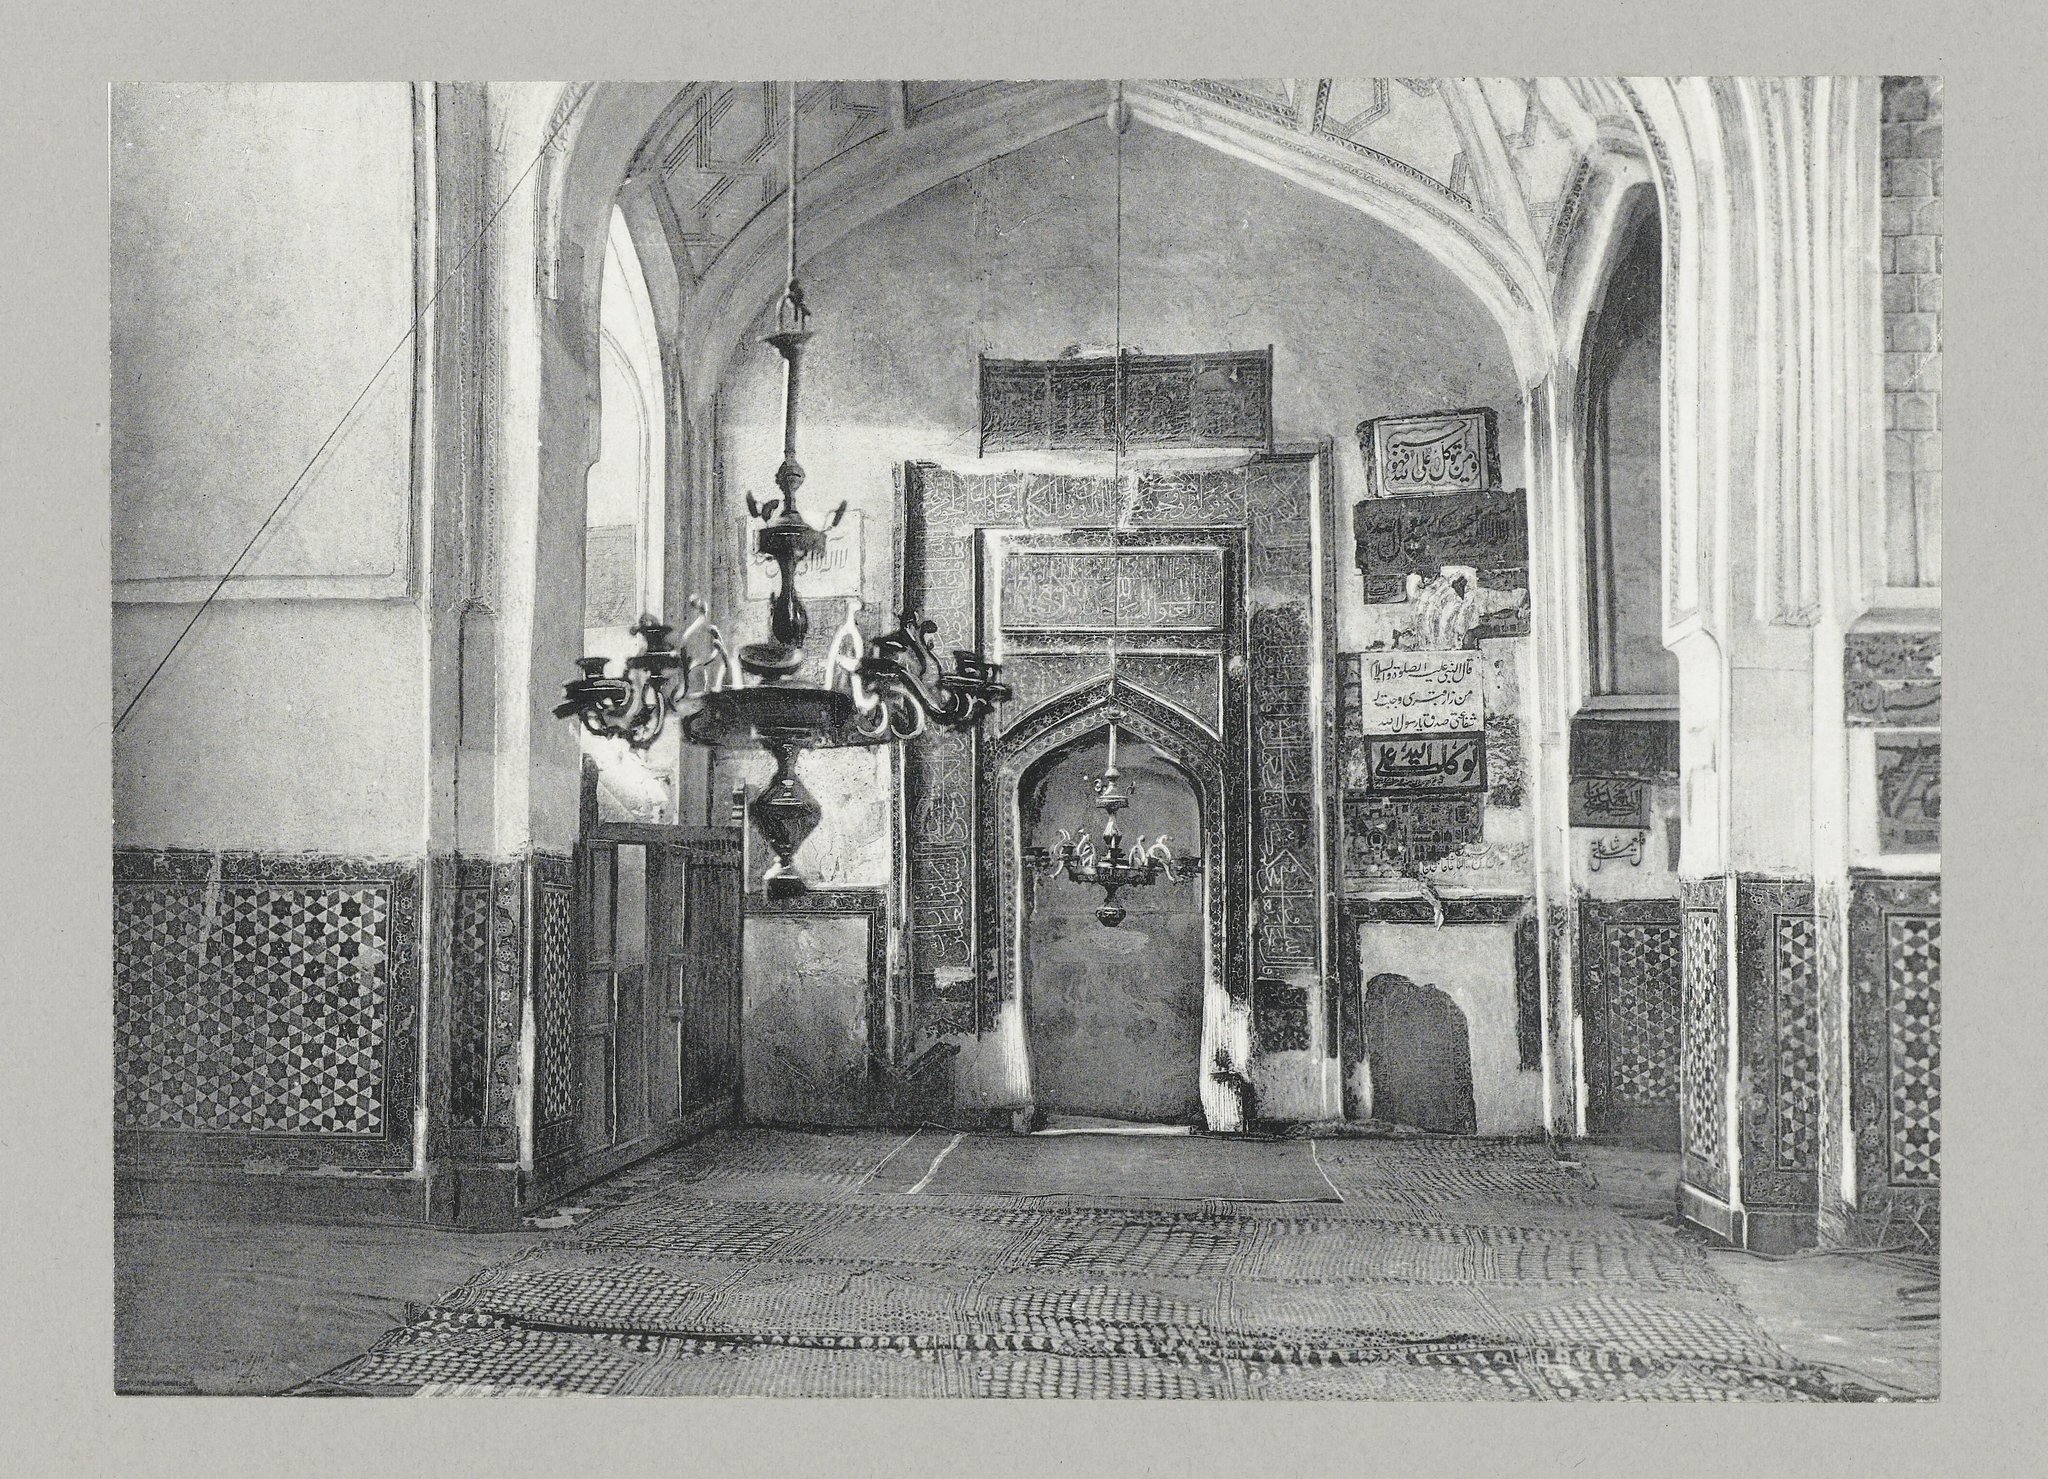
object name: photomechanical print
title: Interieur van moskee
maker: Anonymous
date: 1895-1915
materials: cardboard, paper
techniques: photograph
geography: samarqand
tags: samarqand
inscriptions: annotation: ‘15. Inwendig der Moskee van Nº 14. (groote Koran).’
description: Binnenkant van de moskee waarvan de ingang te zien is op RP-F-00-5344-14.